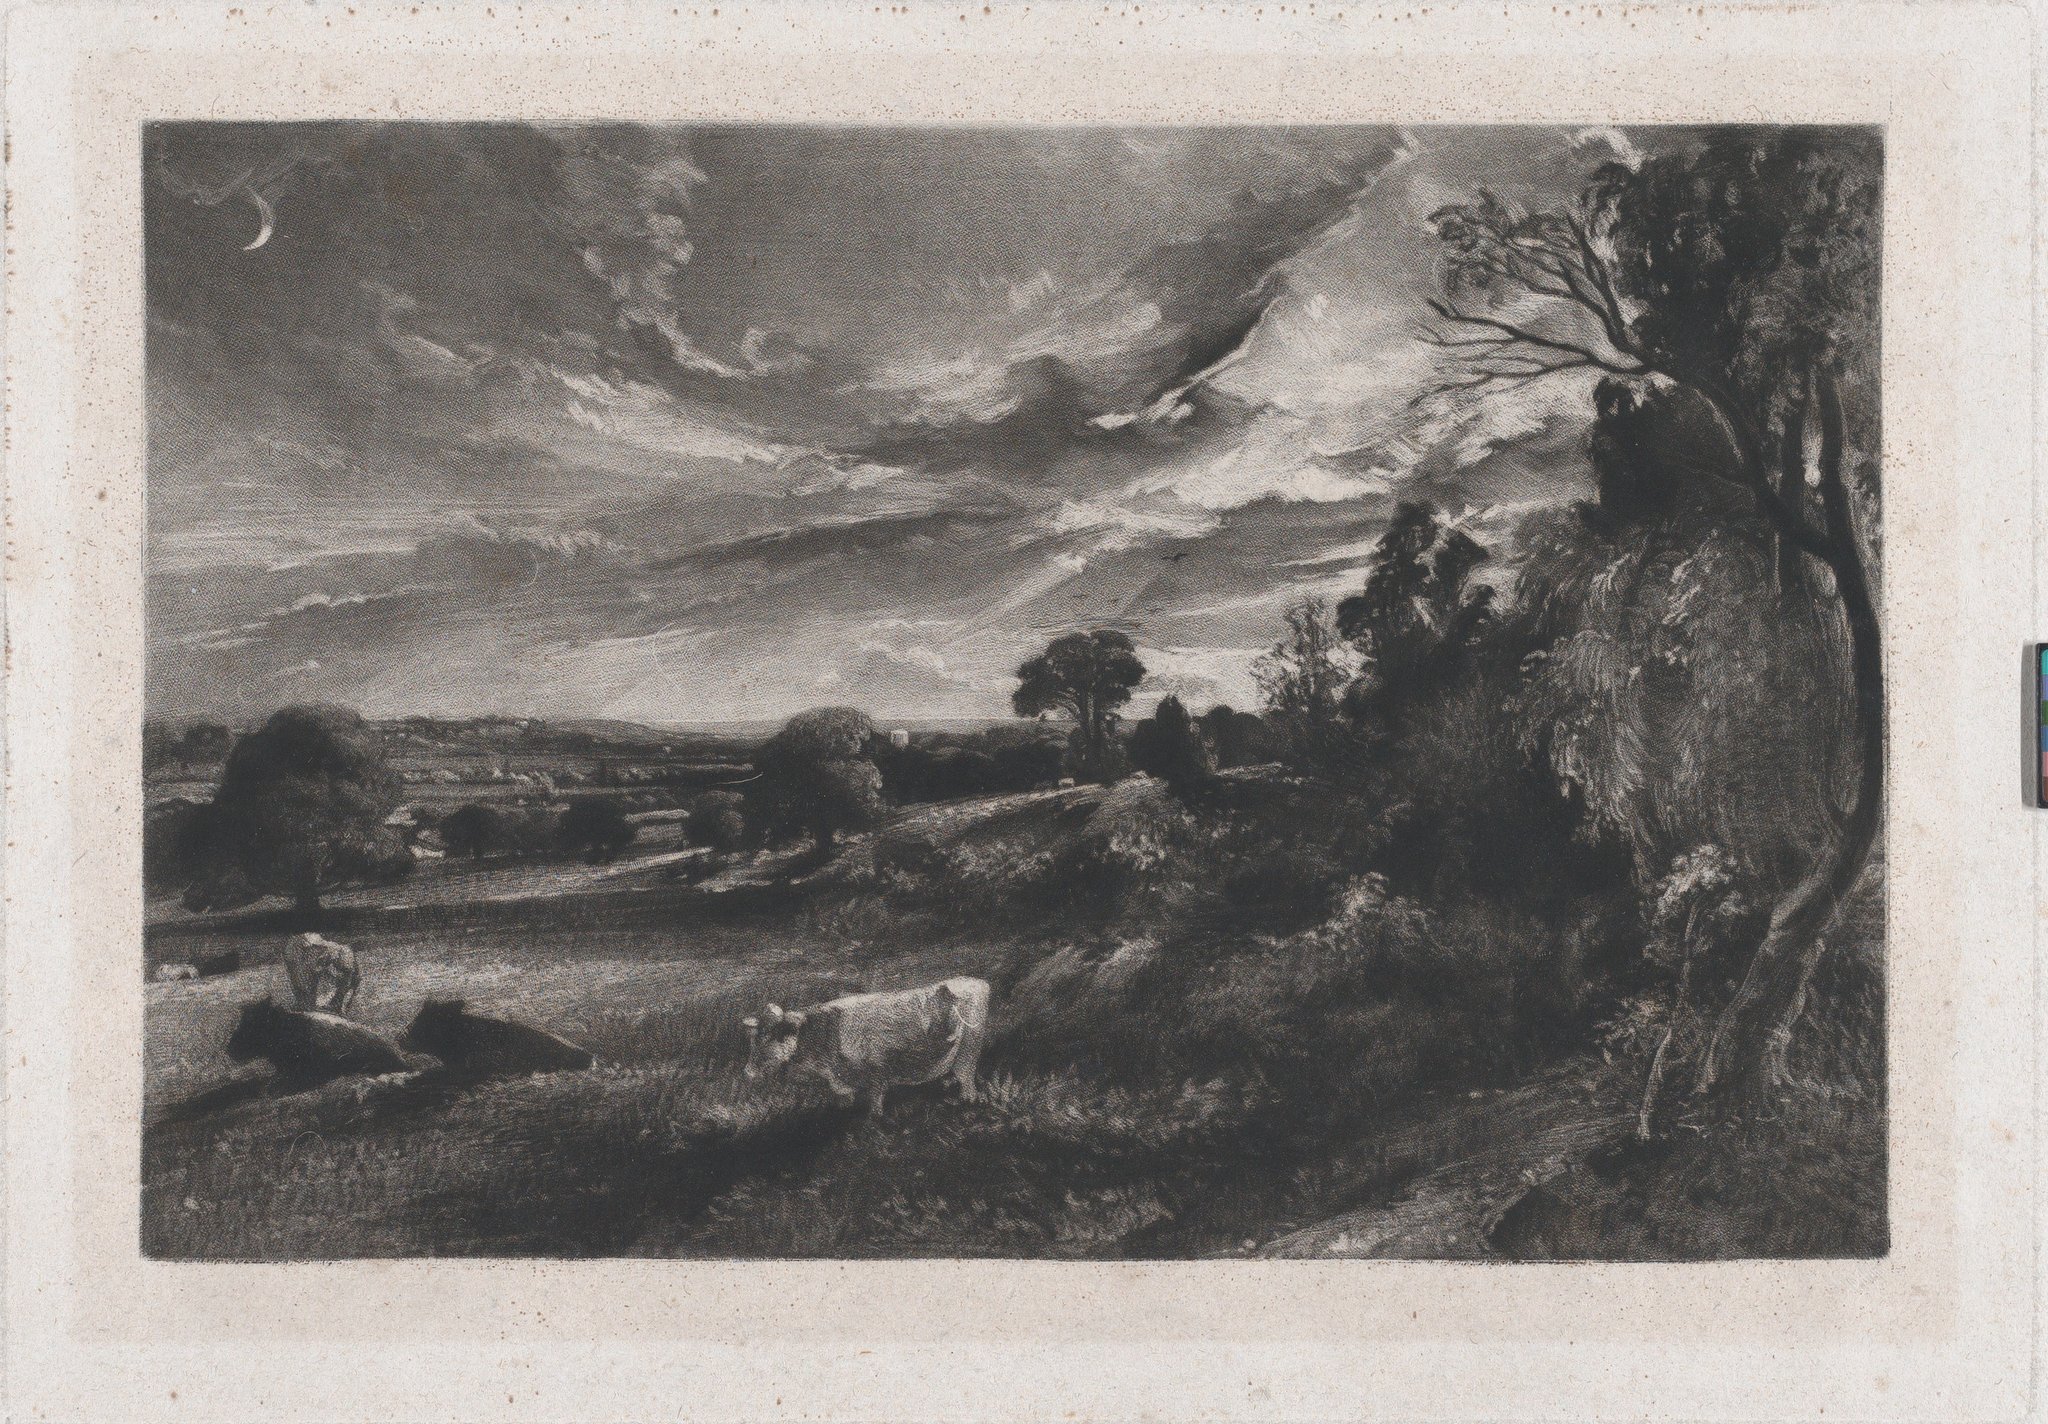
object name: print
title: Summer Evening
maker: david lucas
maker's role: artist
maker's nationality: british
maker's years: 1802-1881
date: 1829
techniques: mezzotint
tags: cows,landscapes,evening